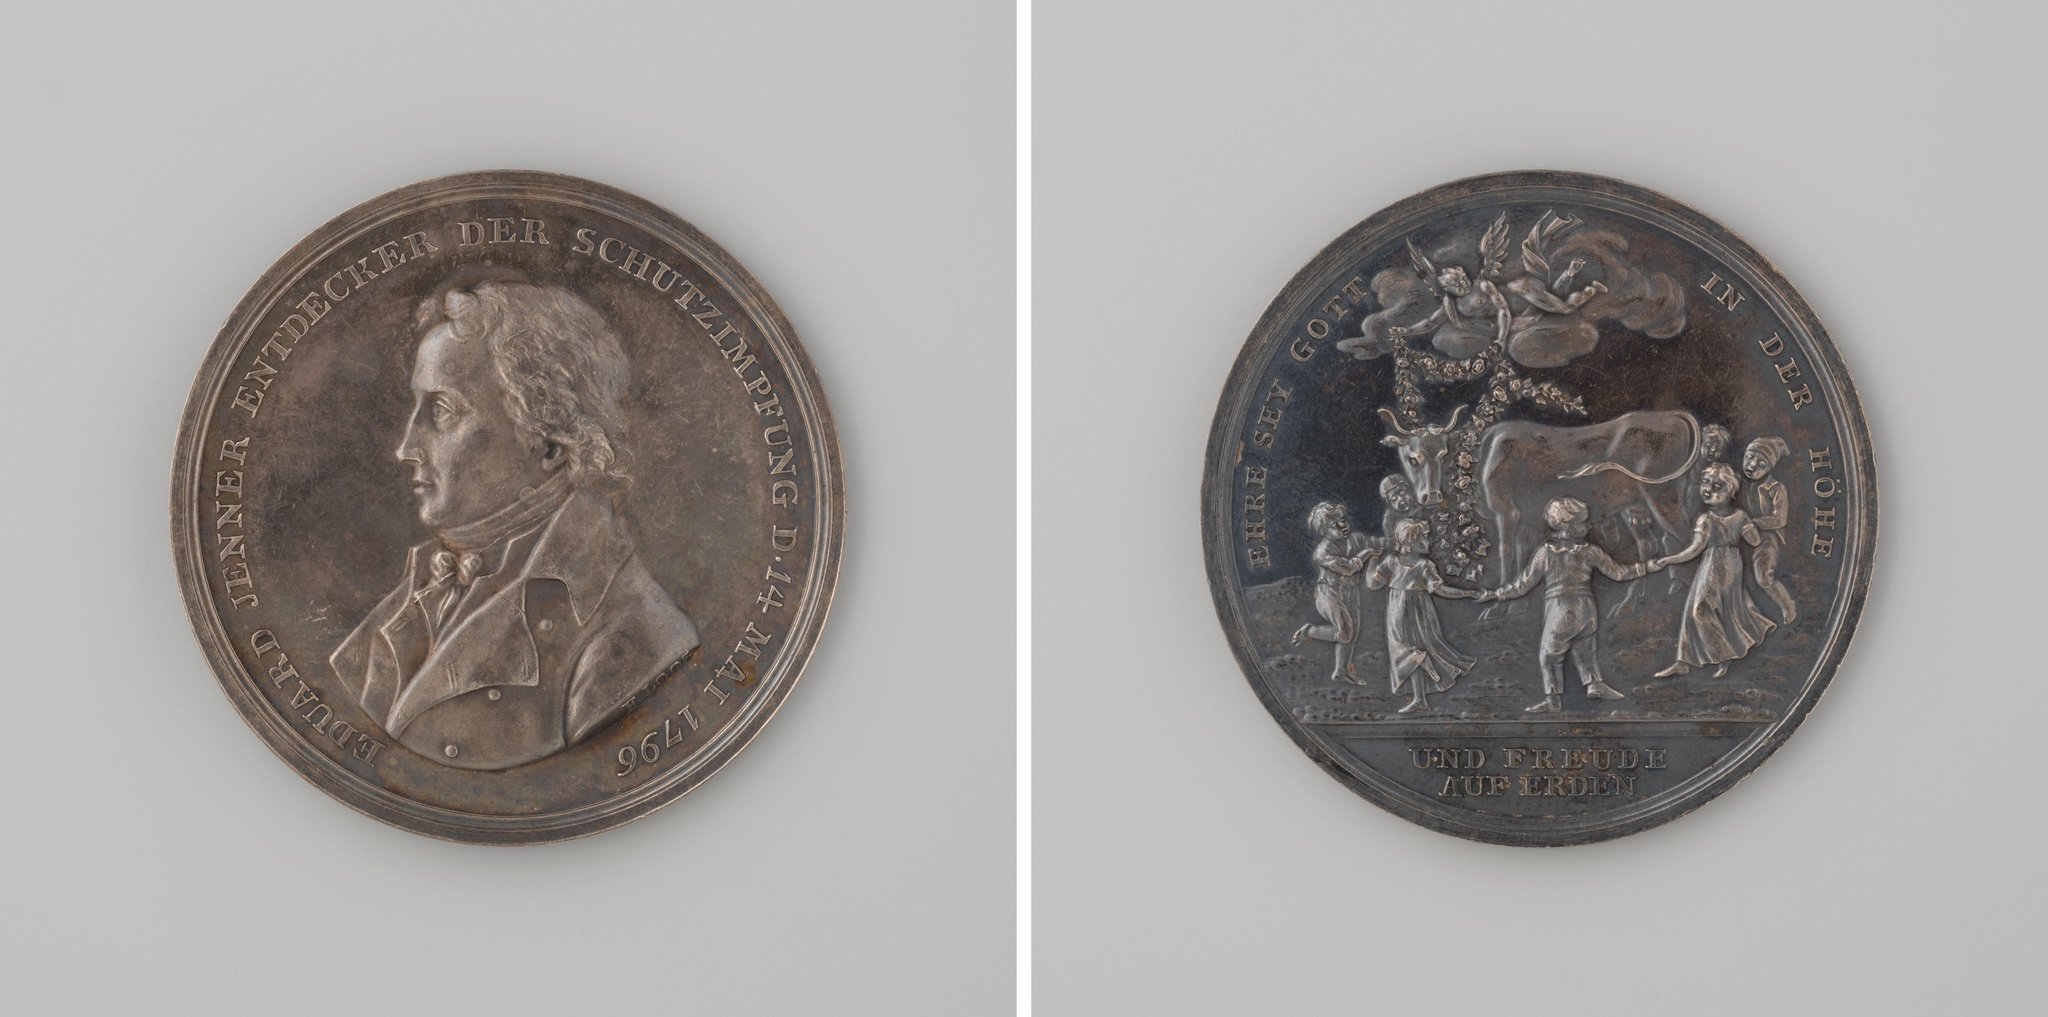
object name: history medal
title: Eduard Jenner, uitvinder van de koepokinenting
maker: friedrich wilhelm loos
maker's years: 1786-1819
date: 1796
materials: silver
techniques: striking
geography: berlin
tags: wetenschapper, arts, edward jenner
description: Zilveren penning. Voorzijde: borststuk man binnen omschrift. Keerzijde: kinderen in kring dansend rond koe, die door engel uit wolken bloemenkrans omgehangen krijgt binnen omschrift; afsnede: opschrift